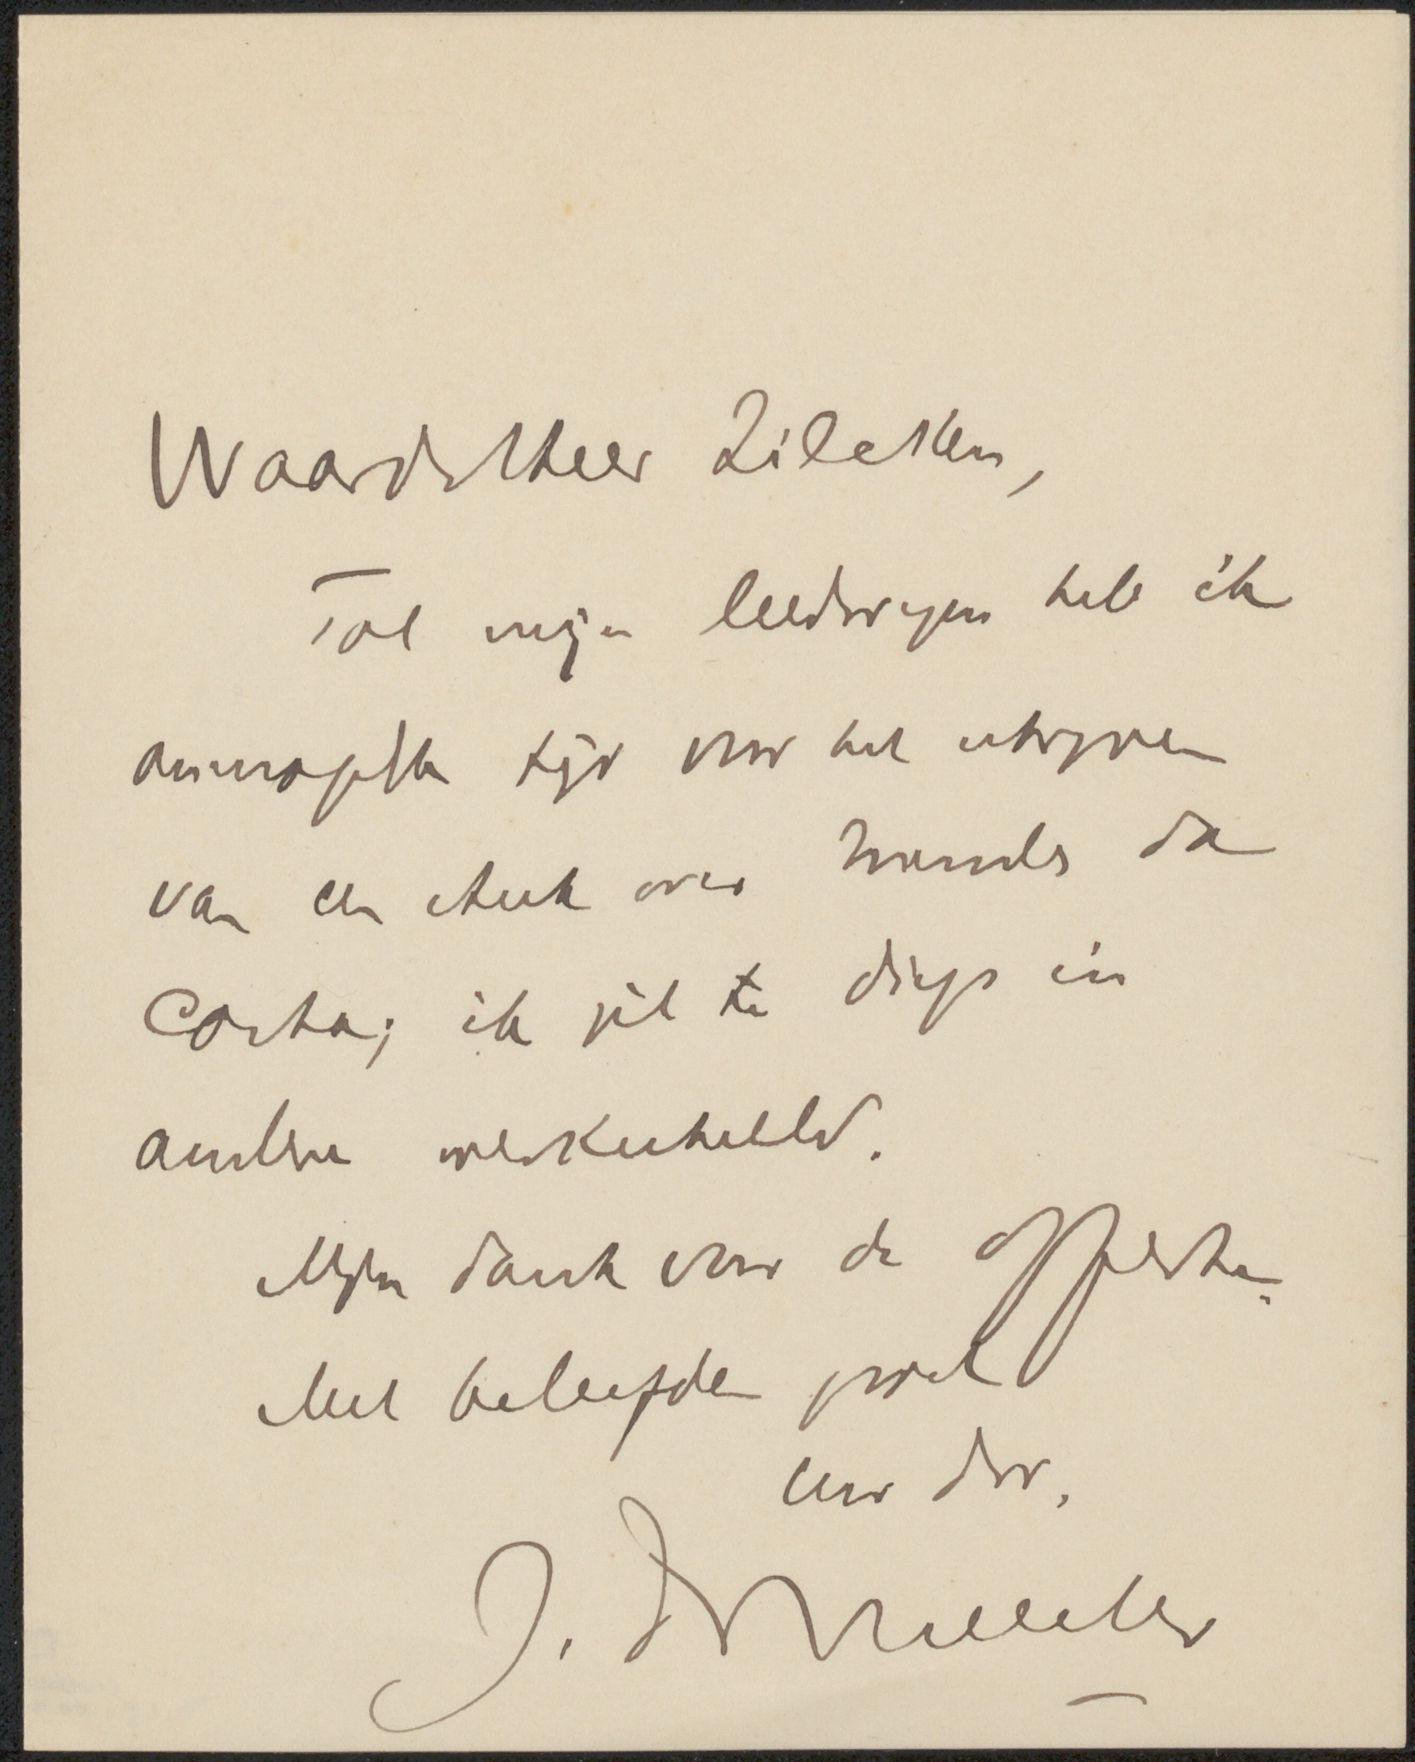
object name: letter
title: Brief aan Philip Zilcken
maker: johan de meester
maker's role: schrijver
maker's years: 1860-1931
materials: ink, paper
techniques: pen, writing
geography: the hague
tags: amsterdam, print maker, joseph mendes da costa (1863-1939), the hague, painter, draughtsman, philip zilcken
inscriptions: collector's mark: ‘RPK’